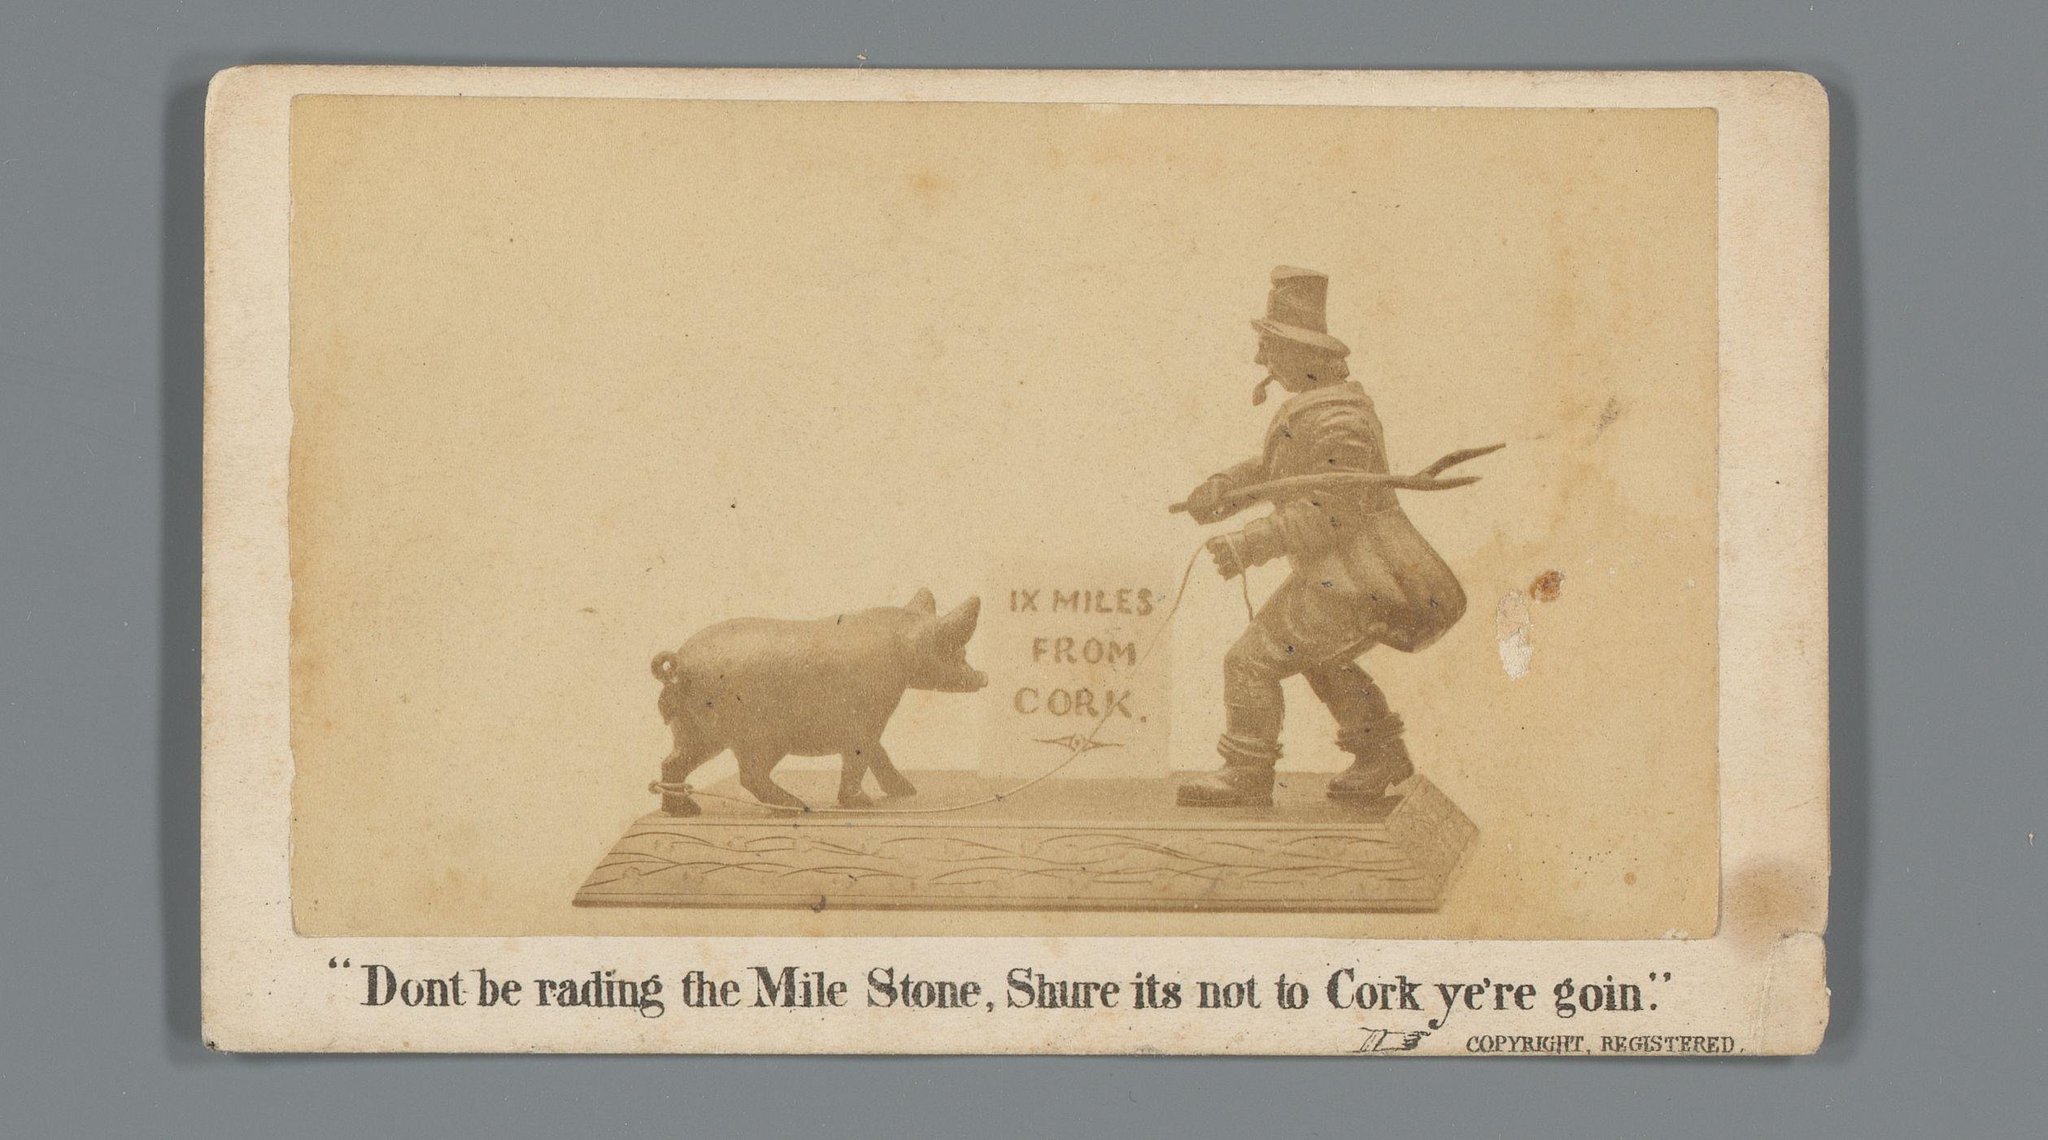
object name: reproduction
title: Reclame voor juwelier S. Samuel uit Dublin met fotoreproductie van een houtsnijwerk van een man met varken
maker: Anonymous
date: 1850-1915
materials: cardboard, photographic support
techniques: albumen print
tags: pig, advertising, handicrafts ~ wood, timber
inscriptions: inscription: ‘PHOTOGRAPHED/ FROM A CARVING/ IN IRISH BOC OAK./ DESIGNED & CARVED/ BY/ S. SAMUEL,/ 29, NASSAU STREET,/ DUBLIN/ BOG OAK ORNAMENTS/ SAMUEL/ JEWELLER/ 29 NASSAU St./ DUBLIN’, inscription: ‘[...] COPYRIGHT, REGISTRED’